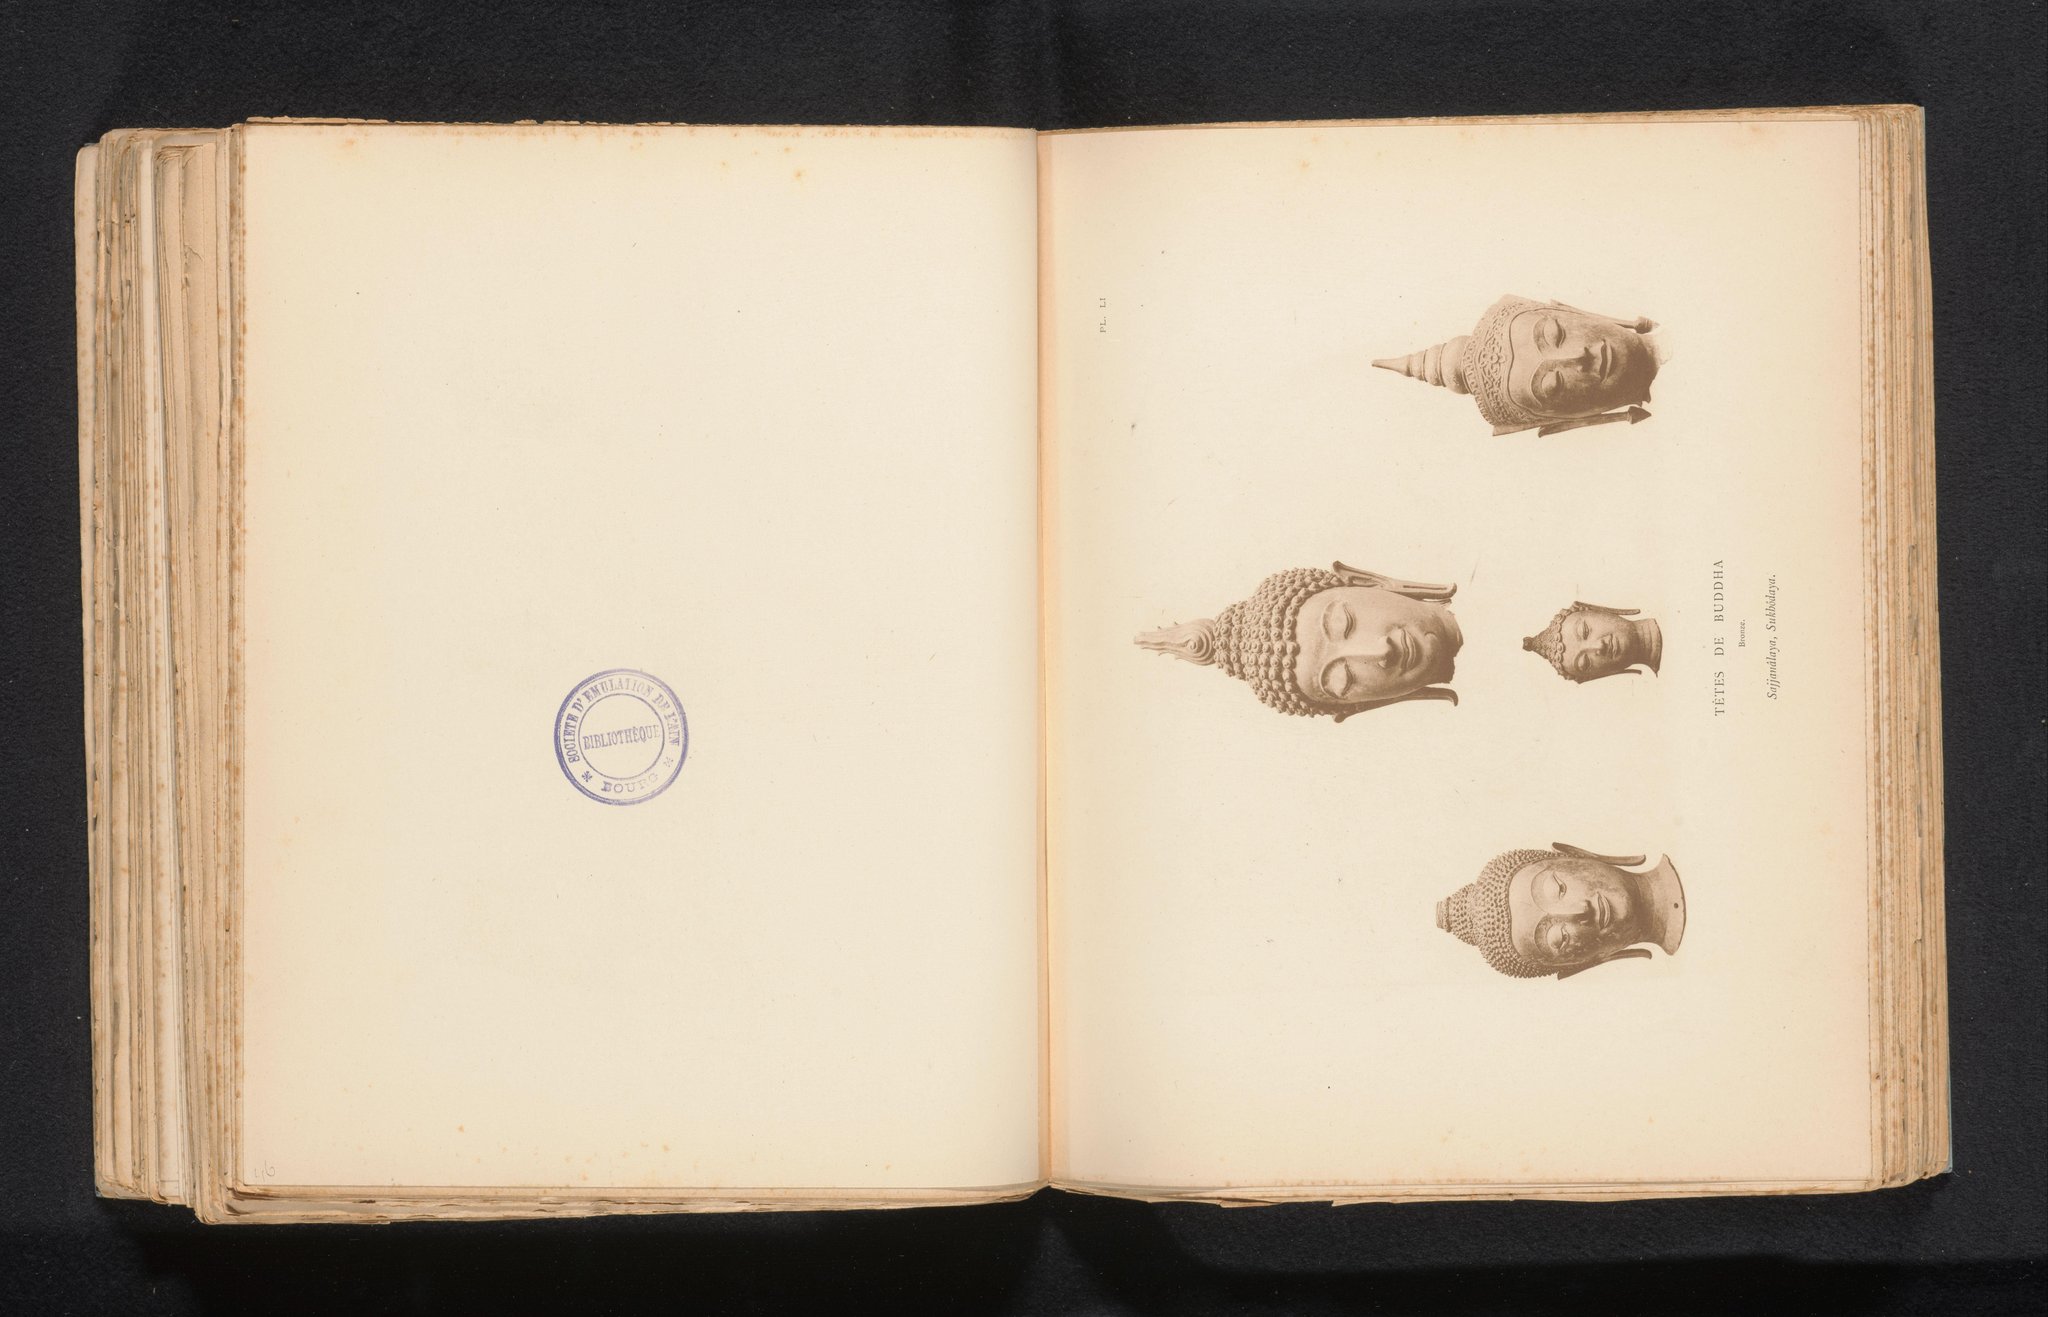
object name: photomechanical print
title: Tètes de Buddha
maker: Anonymous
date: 1890-1895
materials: paper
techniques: photograph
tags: representations ~ gods, demi-gods, heroes, etc. (hinduism, buddhism, jainism)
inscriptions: inscription: ‘Pl. LI’, inscription: ‘Bronze/ Sajjanâlaya Sukhôdaya’, collector's mark: ‘Société d'Emulation de l'Ain/ Bourg/ Bibliothèque’